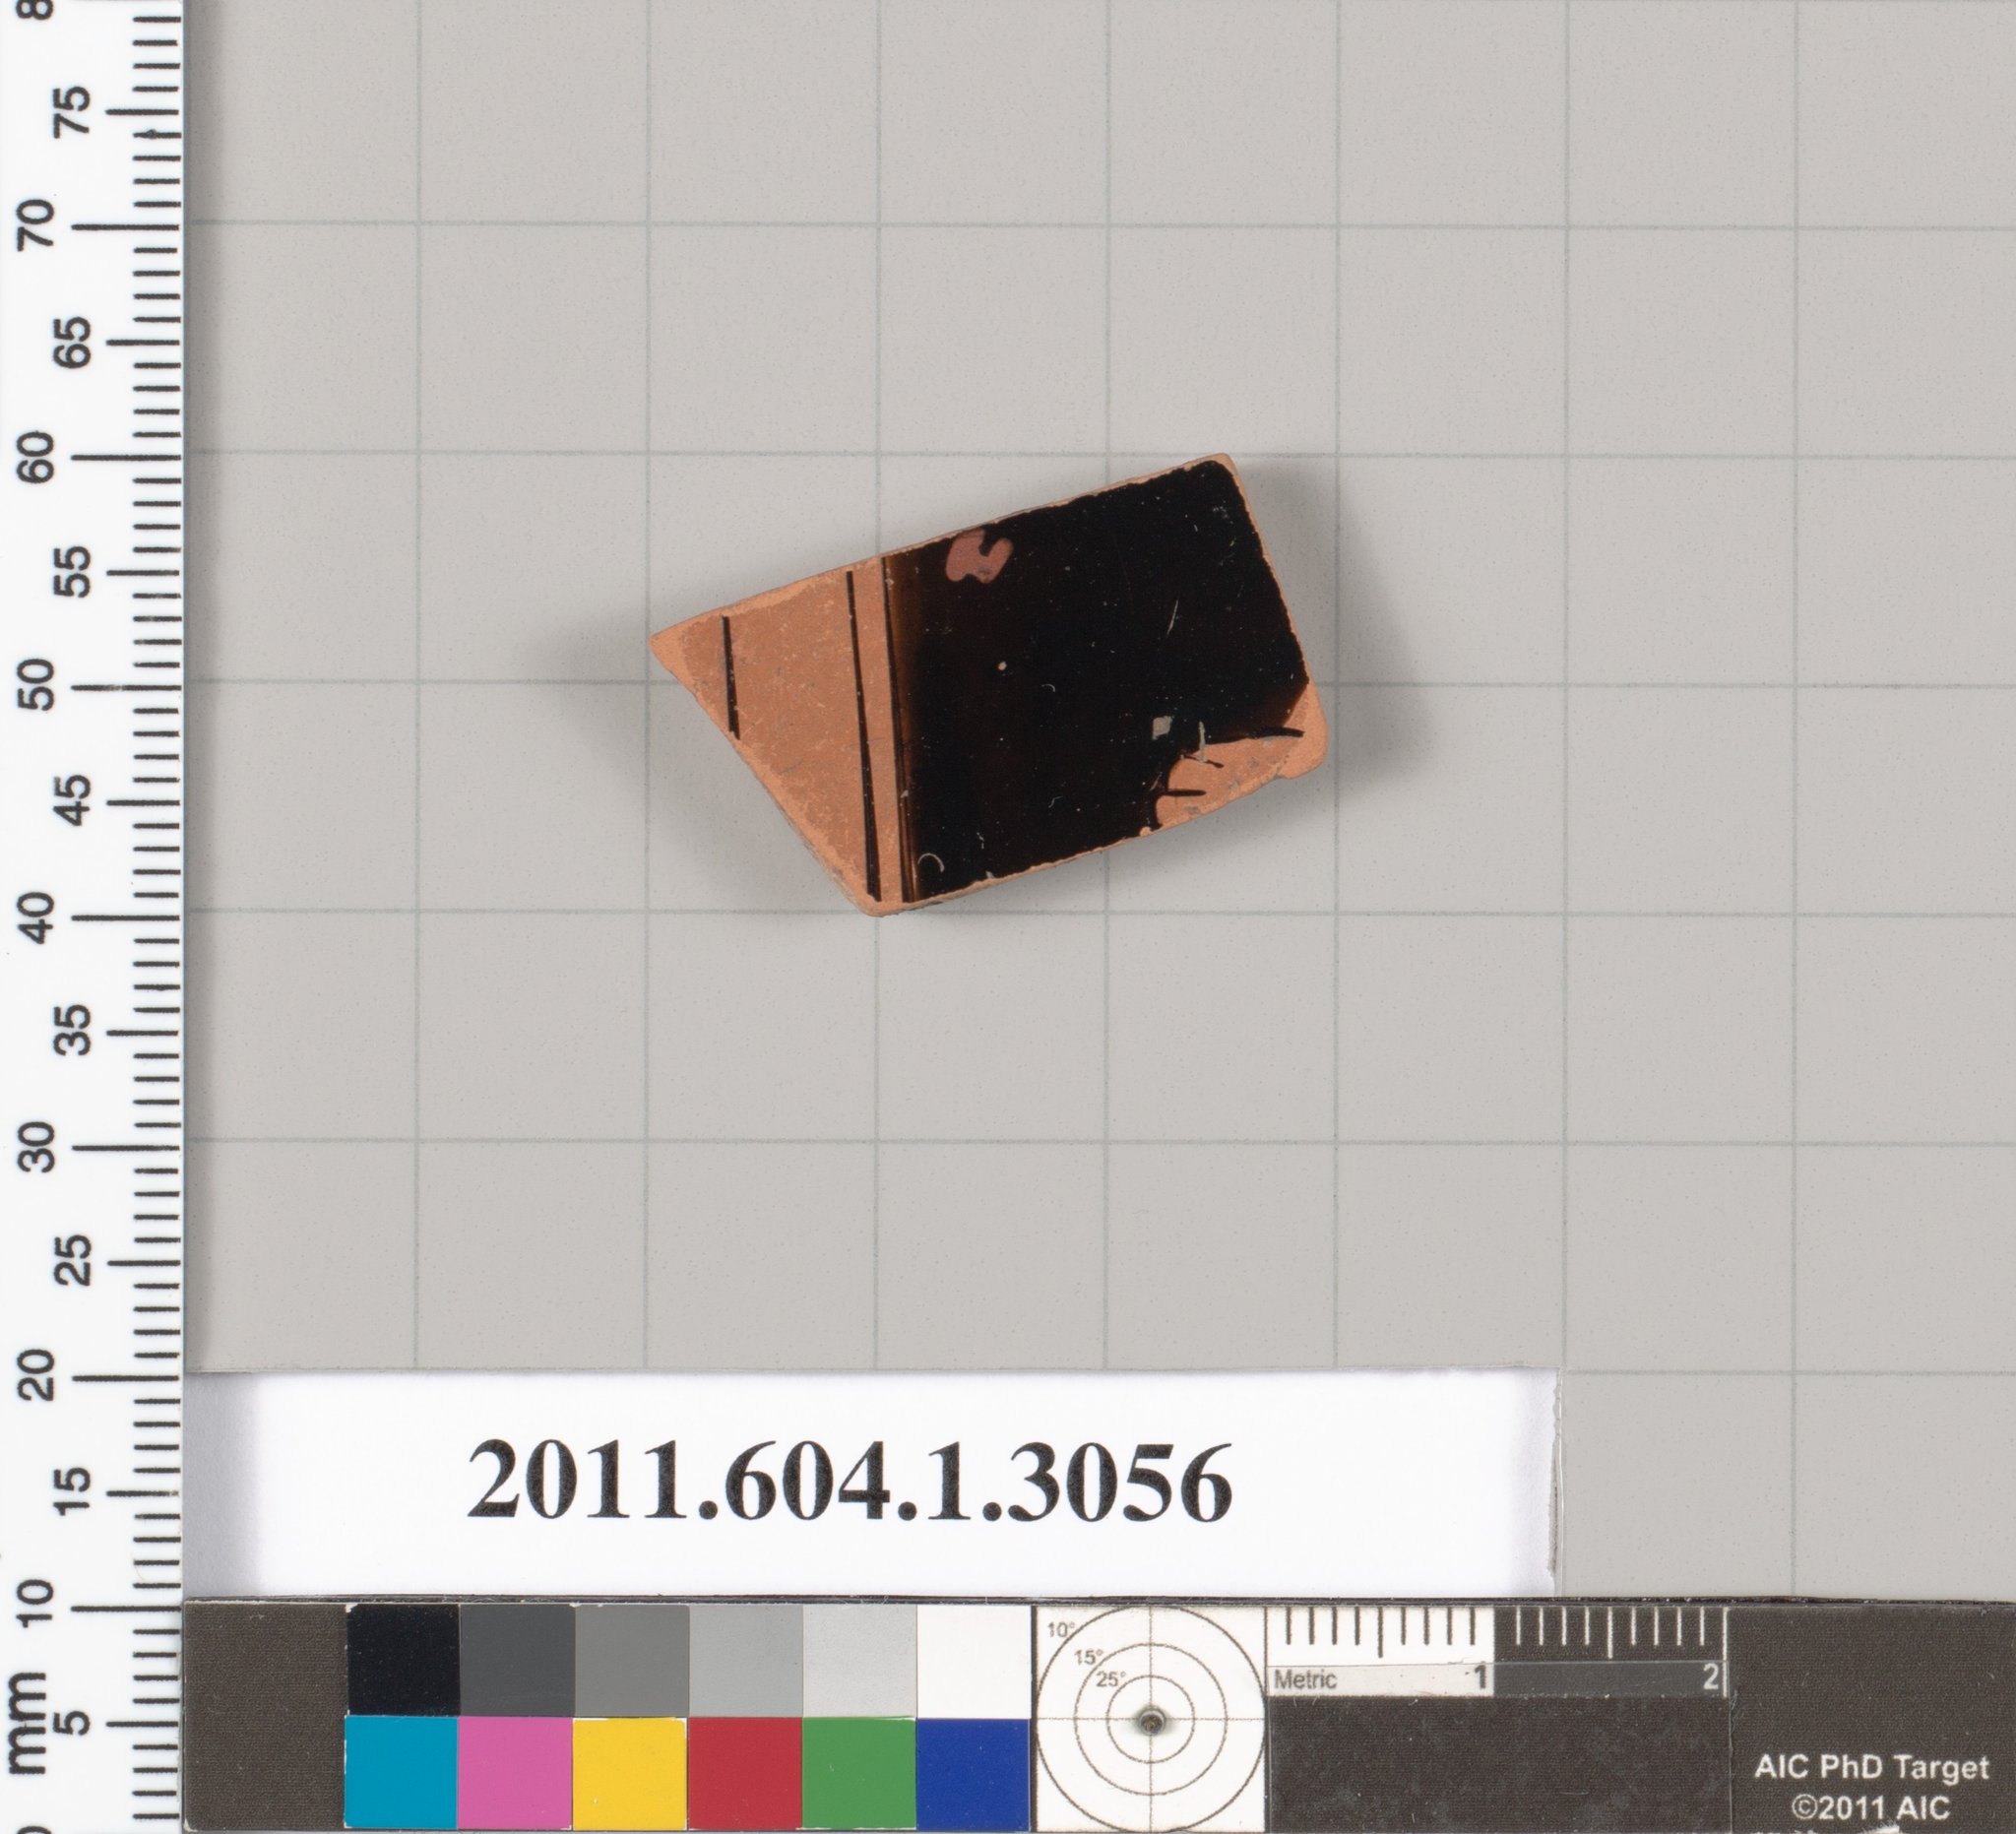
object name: kylix fragment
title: Terracotta fragment of a kylix (drinking cup)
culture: greek, attic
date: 475-451 BCE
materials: terracotta